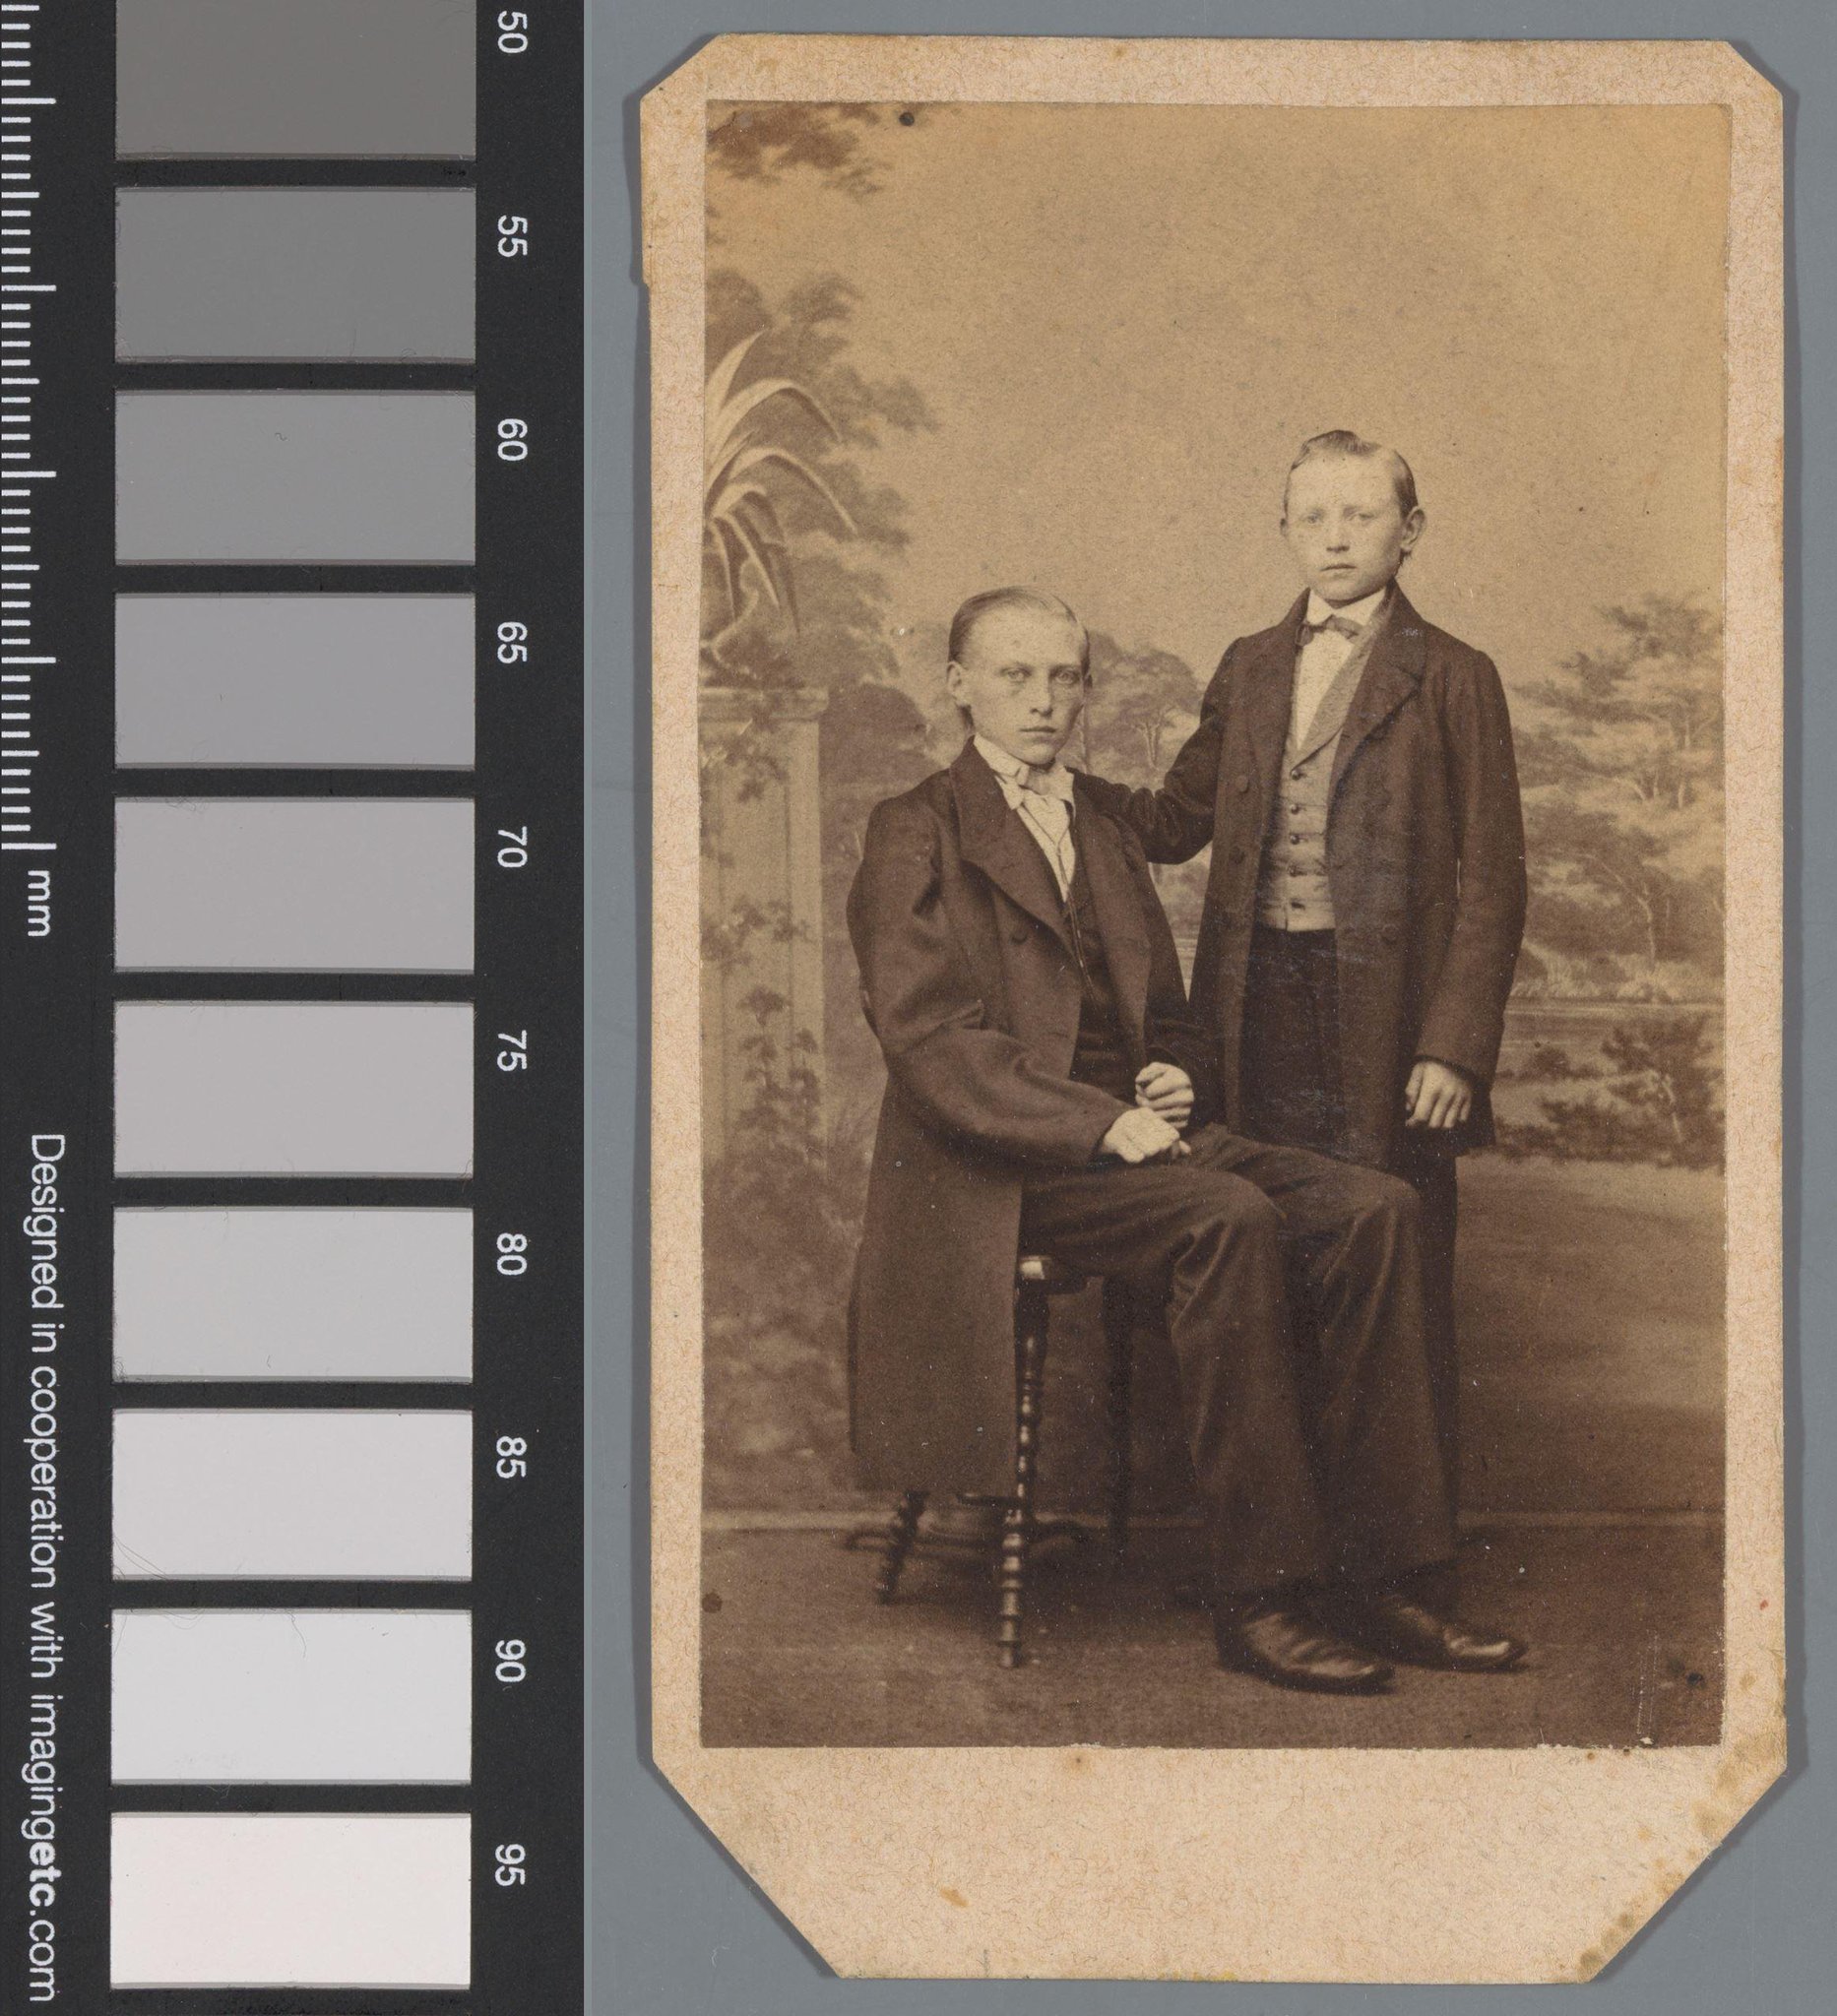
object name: photograph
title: Portret van twee onbekende jongens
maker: carl lucke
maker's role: fotograaf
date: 1864-1876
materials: cardboard, paper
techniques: albumen print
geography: grabowo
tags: boy (child between toddler and youth), anonymous historical person portrayed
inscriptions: inscription: ‘Carl Lucke/ Photograph/ Grabow bei Stettin/ Breite Str. 112.’